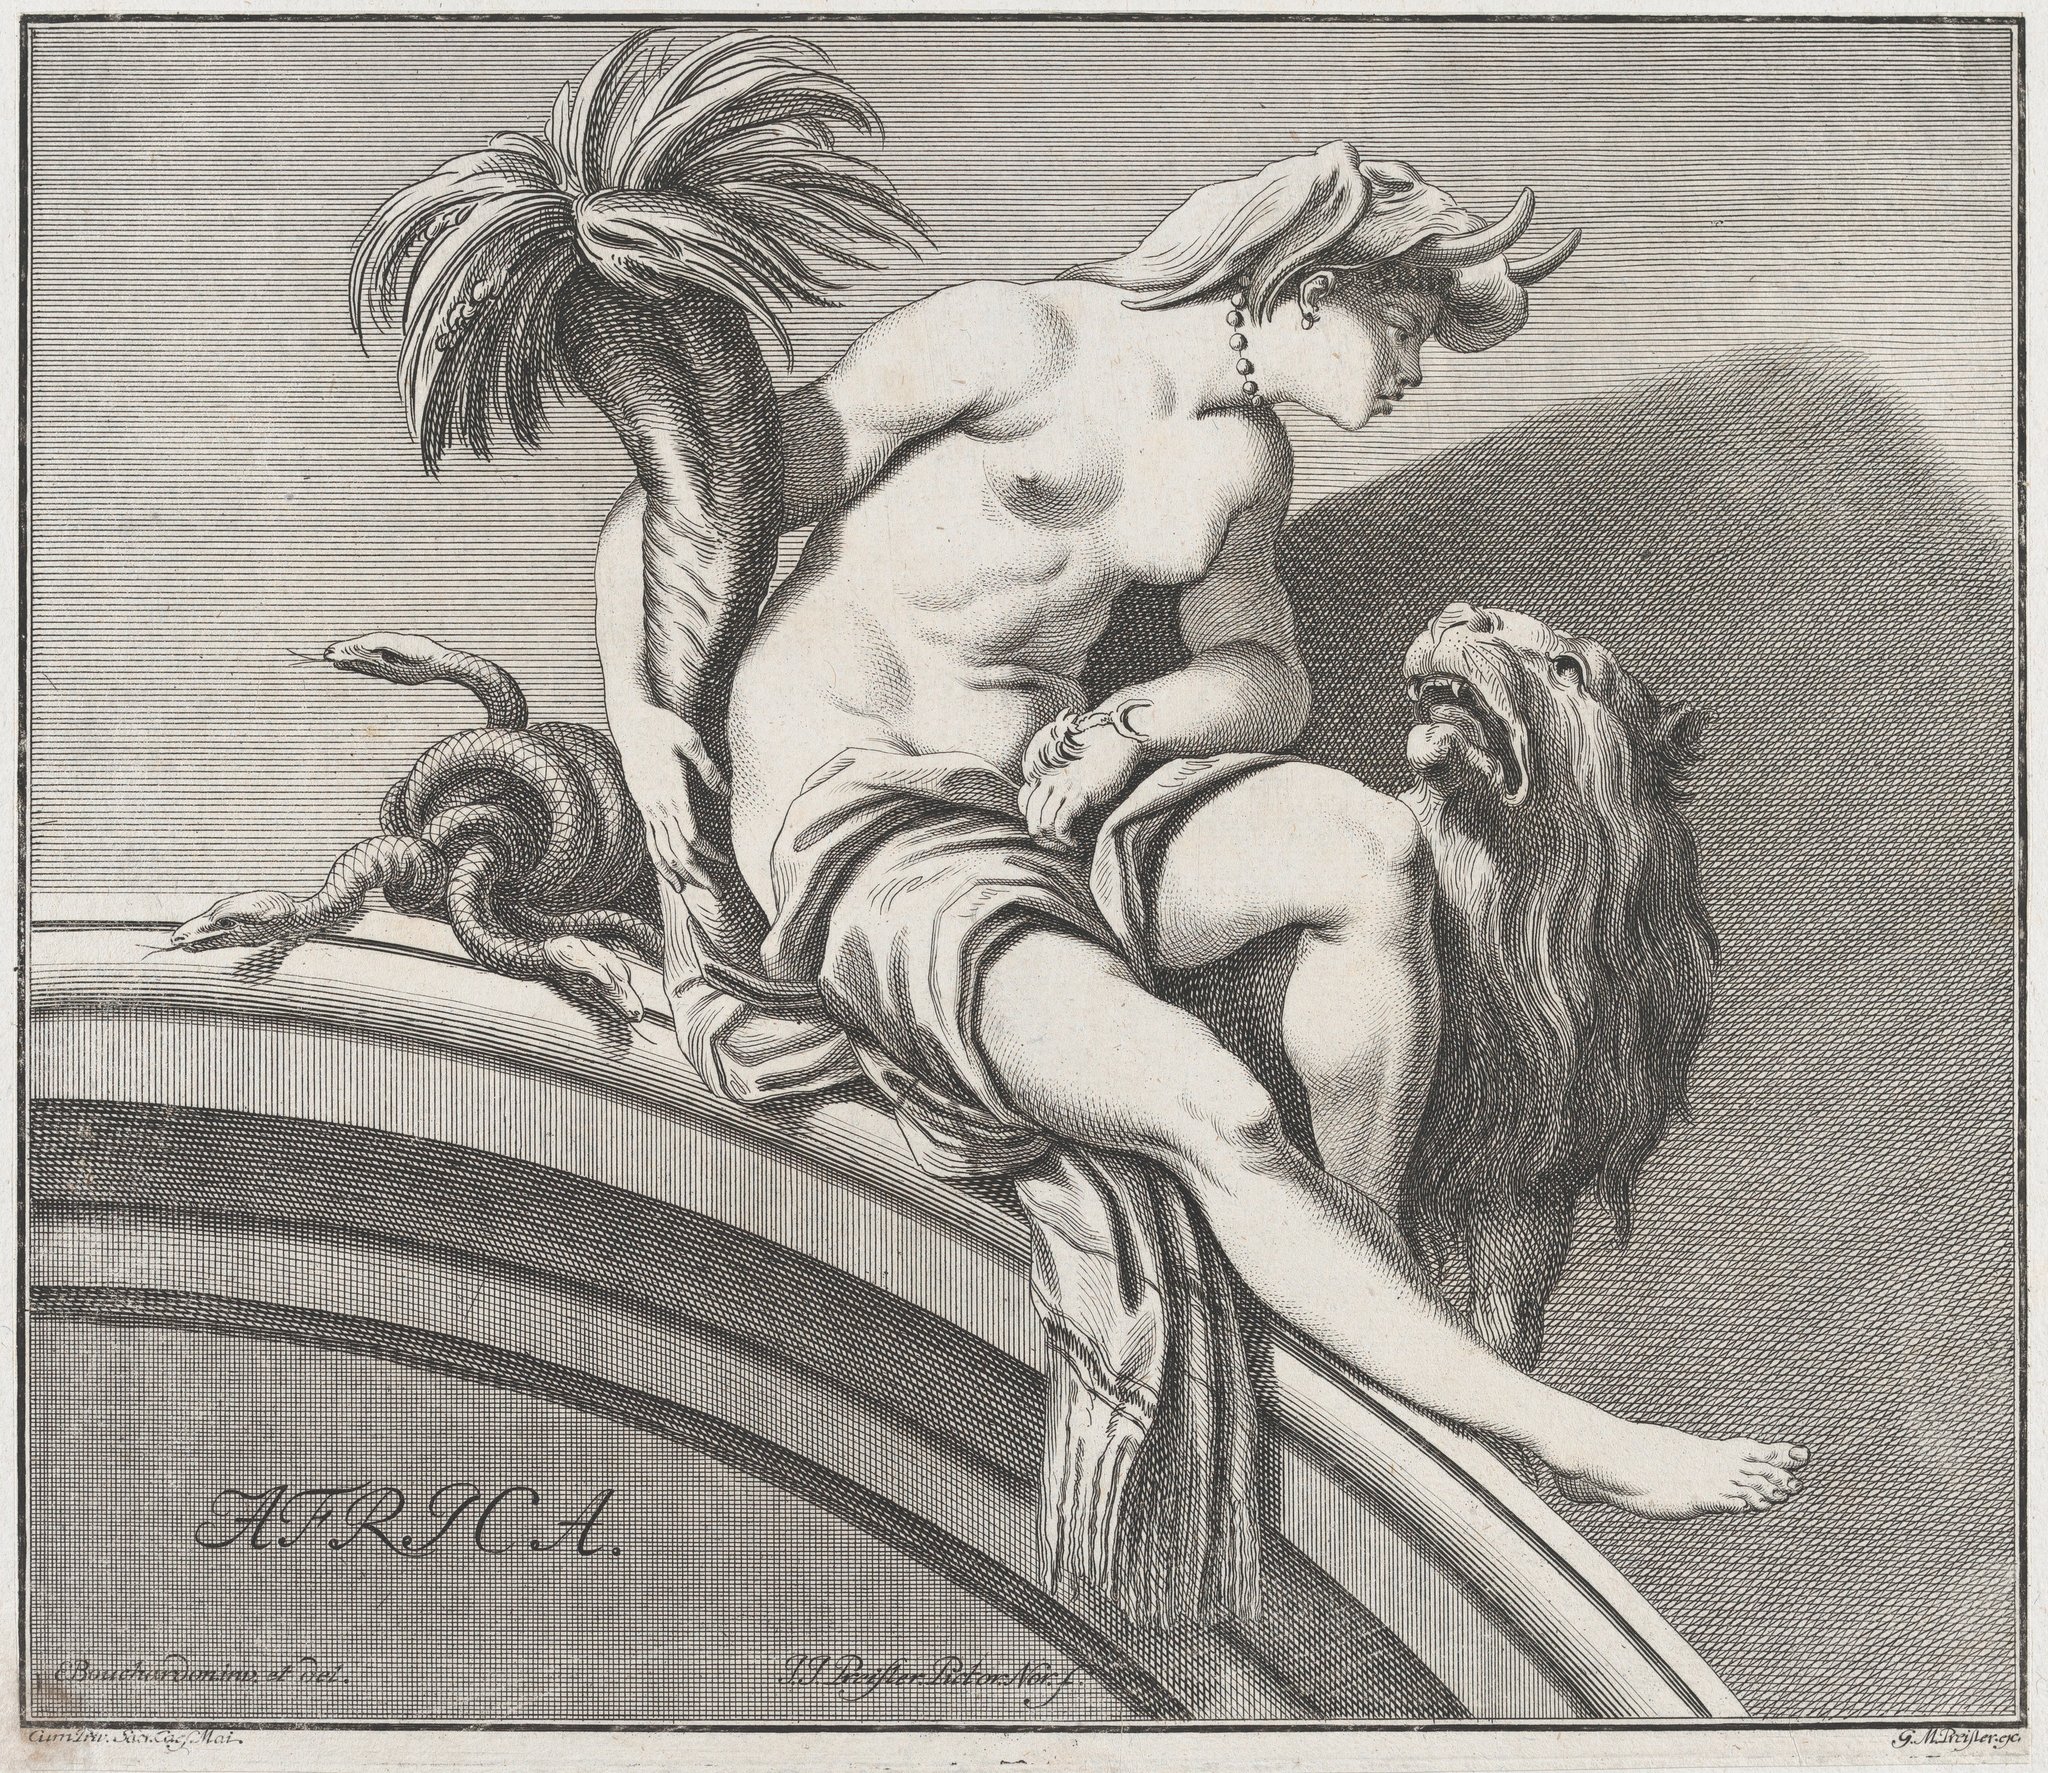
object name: print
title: Allegory of Africa, from "The Four Continents"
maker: johann justin preissler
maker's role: artist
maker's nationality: german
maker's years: 1698-1771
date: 1732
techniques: engraving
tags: female nudes,lions,snakes